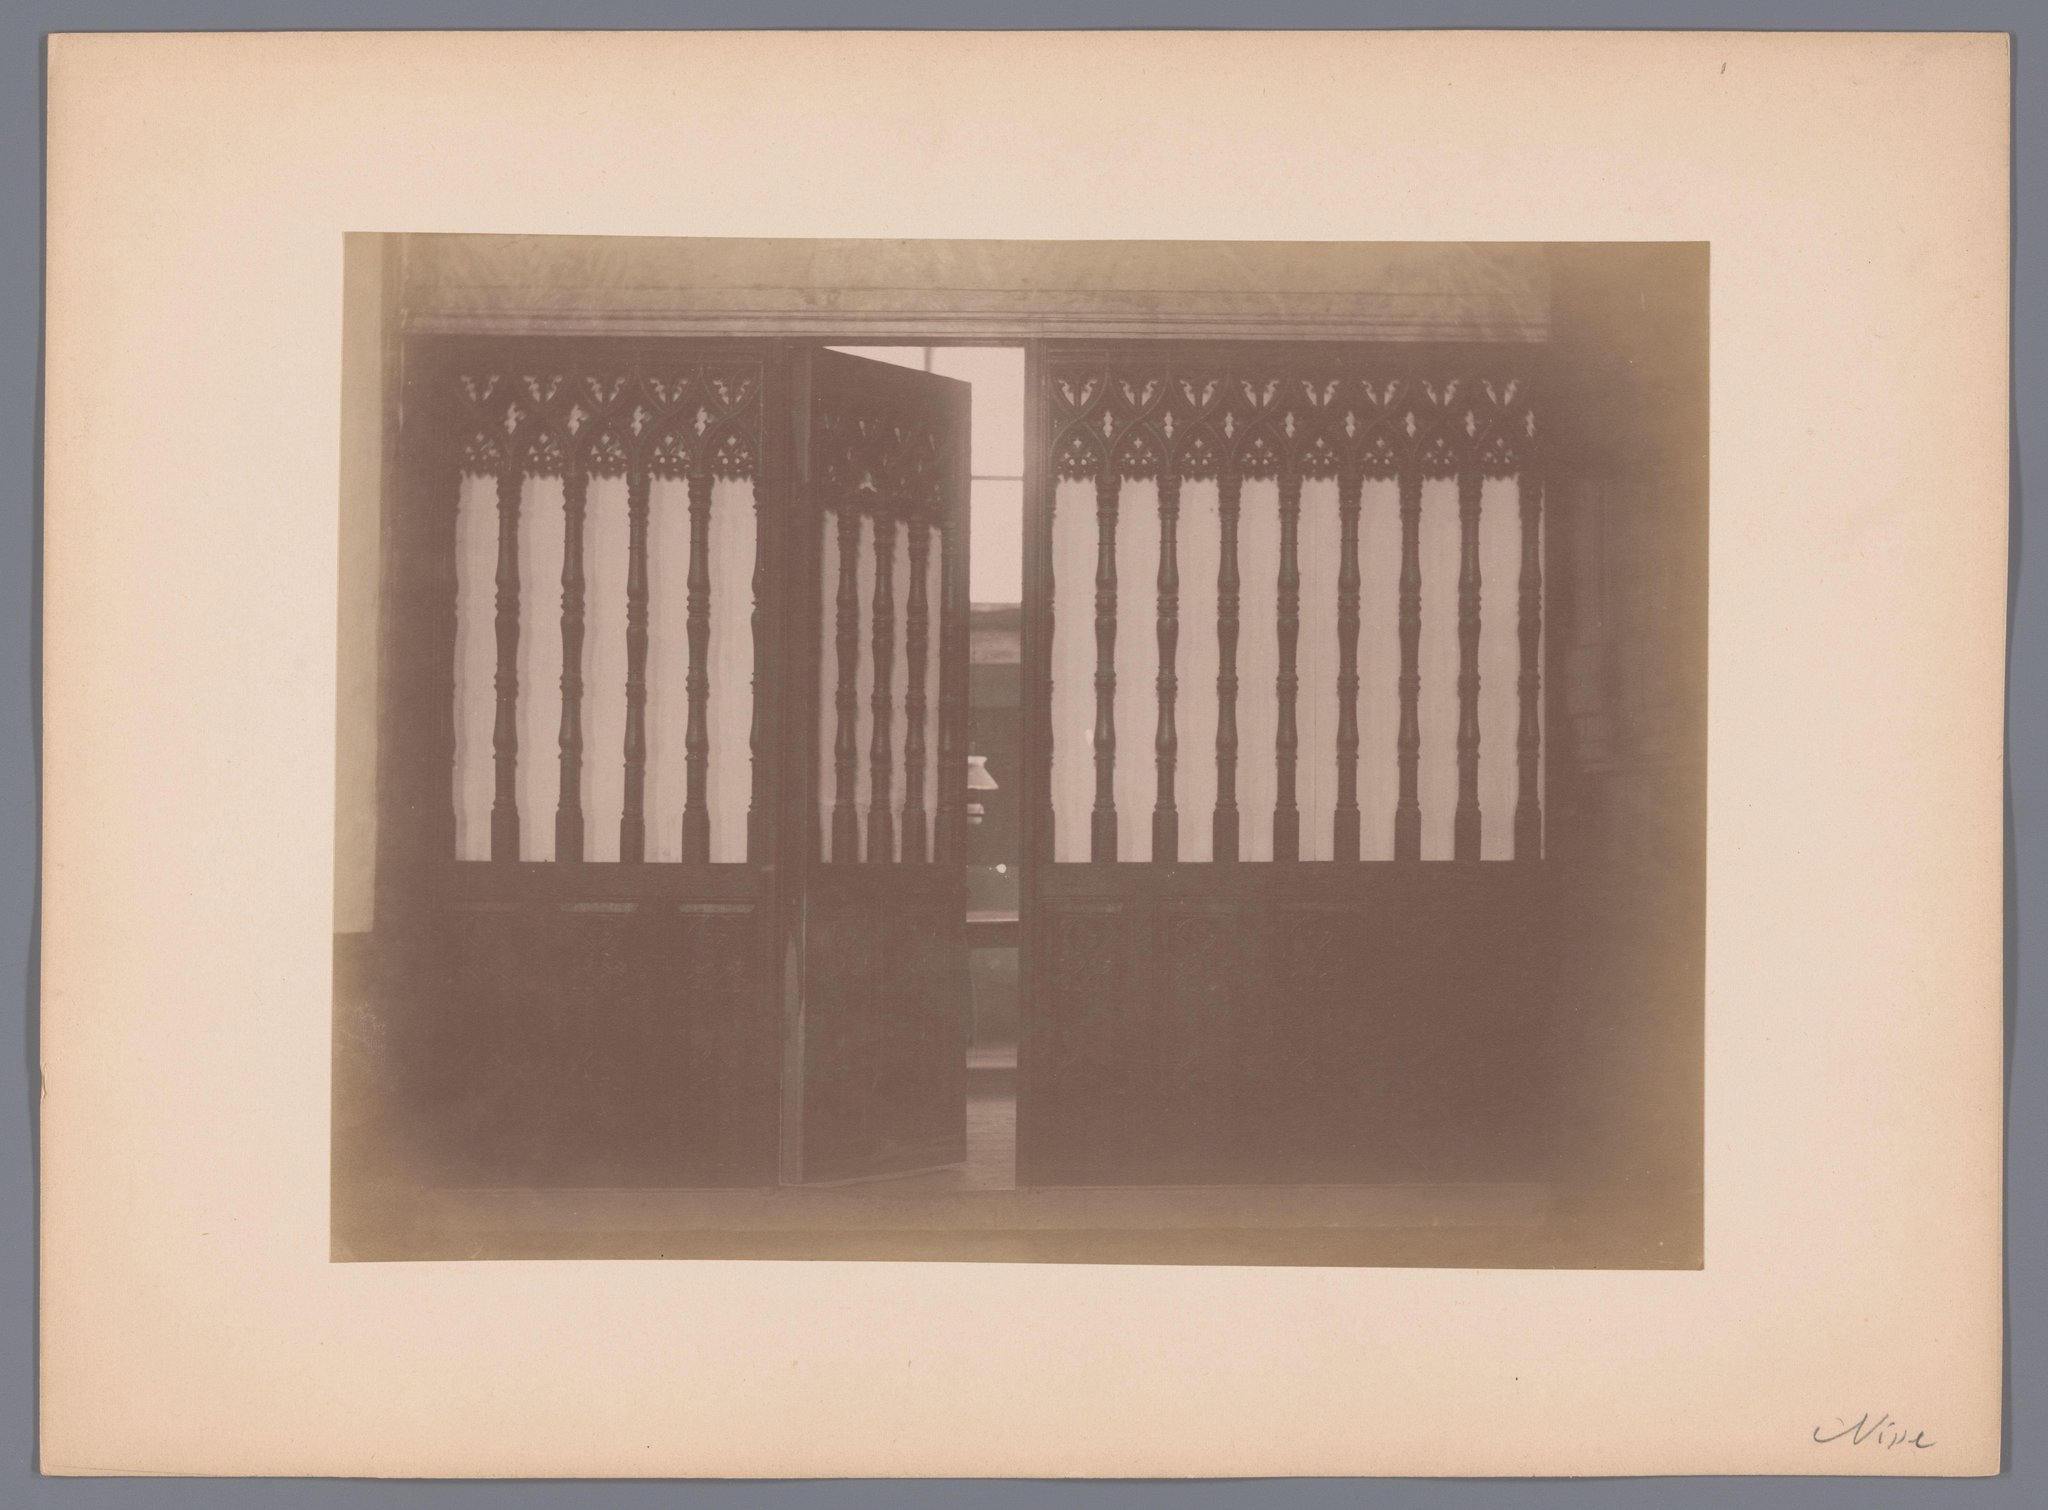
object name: photograph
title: Hek in de Hervormde Kerk te Nisse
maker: anoniem (monumentenzorg)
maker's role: fotograaf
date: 1901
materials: cardboard, photographic support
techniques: albumen print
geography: nisse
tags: parts of church interior: transept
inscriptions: annotation: ‘Nisse’, annotation: ‘Nisse (Zeeland)/ Afsluithek van het transept in de Ned. Herv. Kerk’